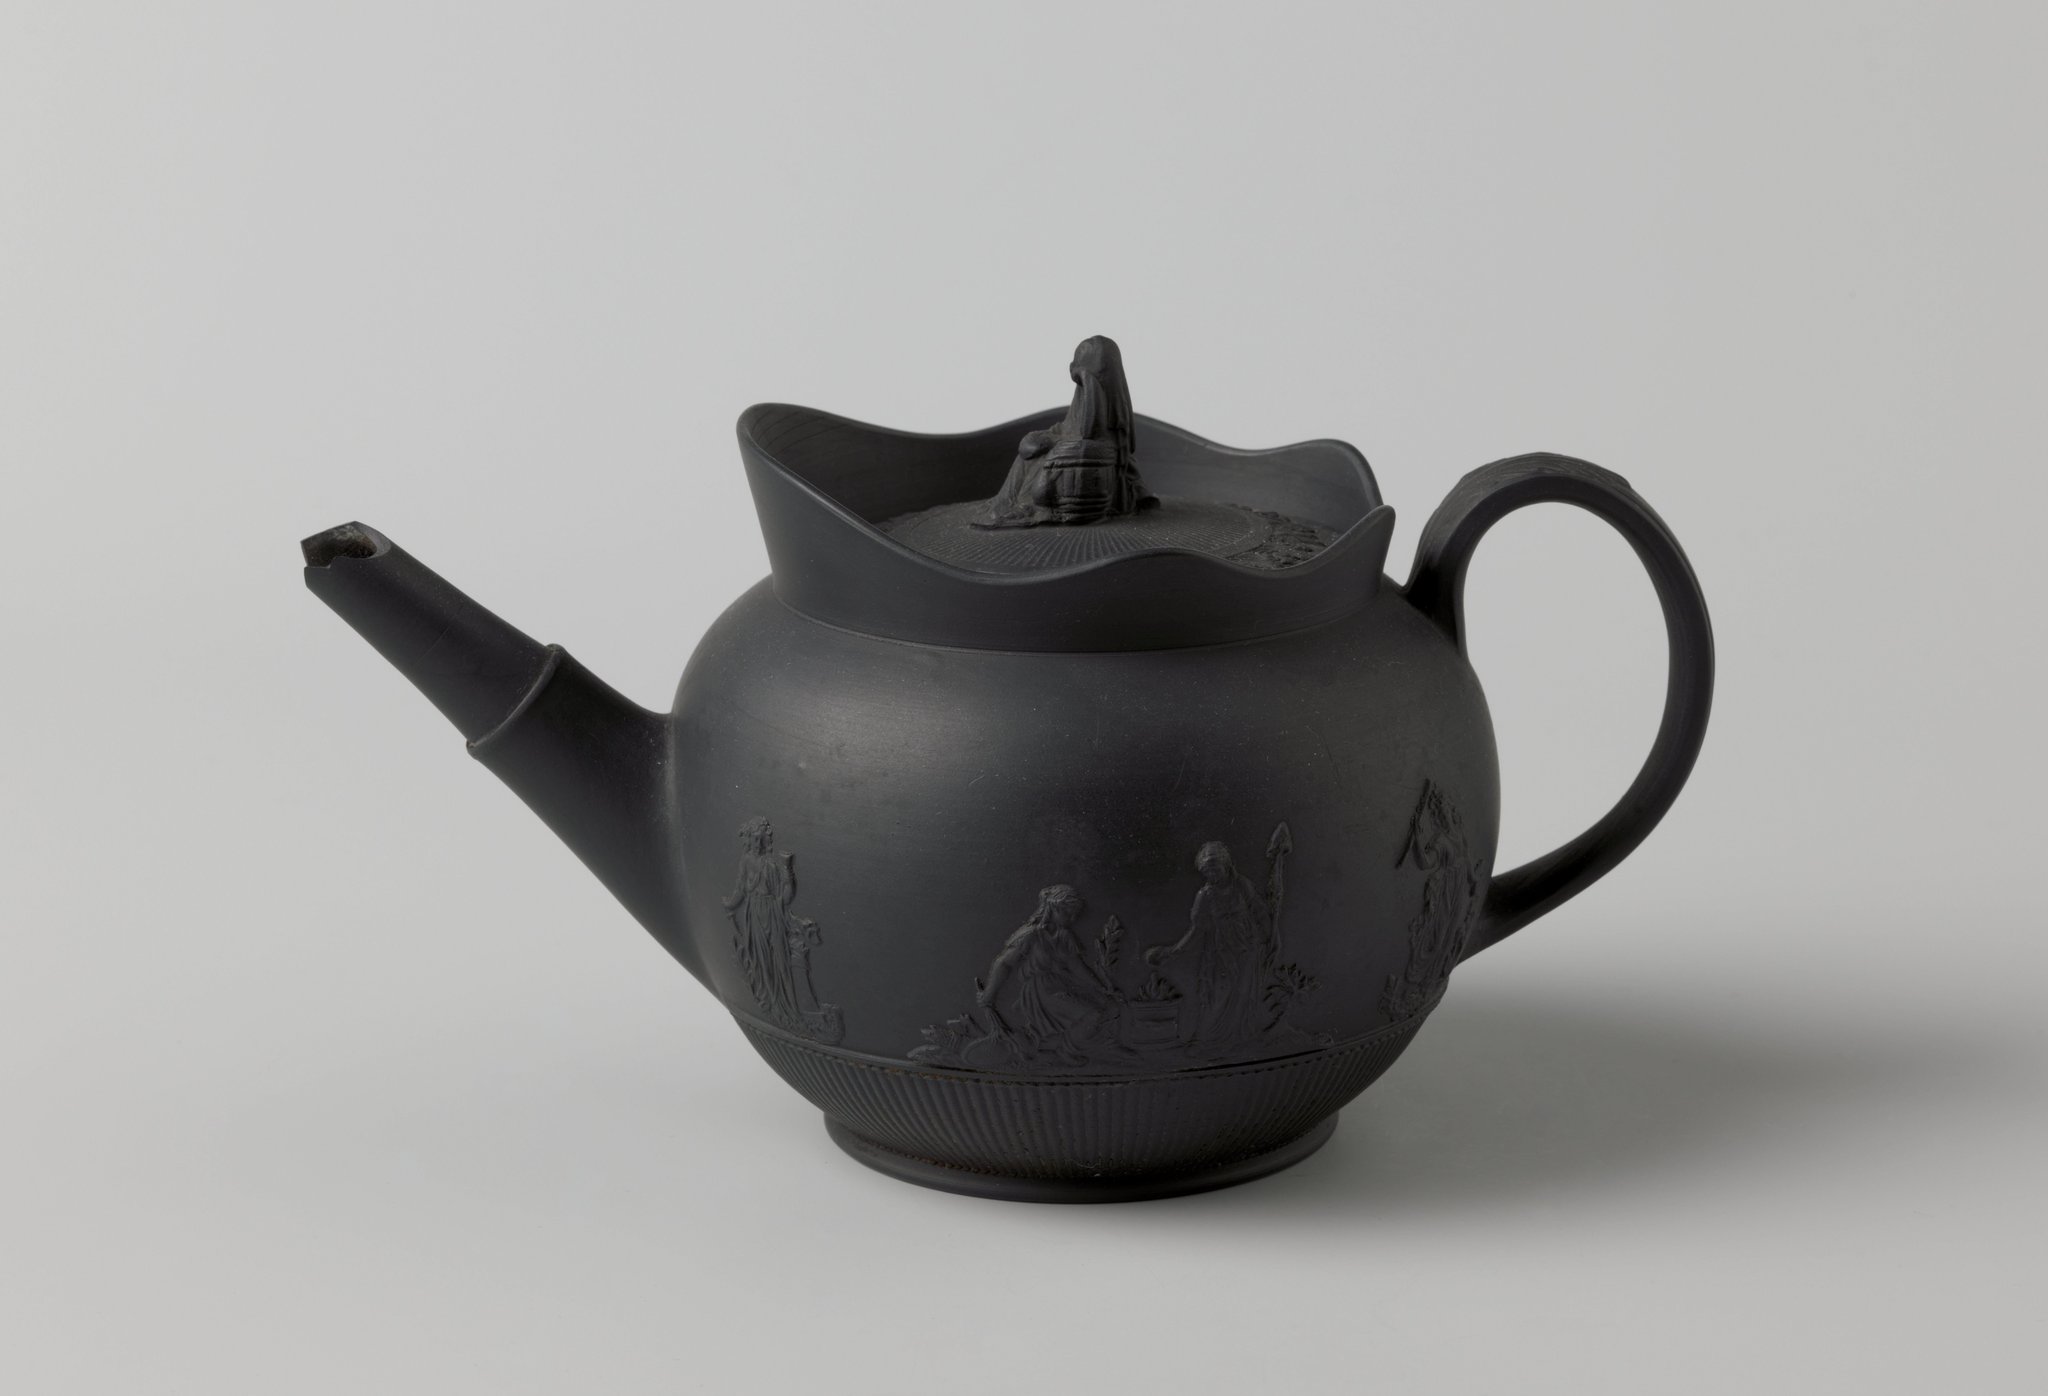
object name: teapot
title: Theepot van aardewerk, E.J. Birch Black Basalt. Met deksel.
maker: edmund john birch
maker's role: aardewerkfabriek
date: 1790-1810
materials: earthenware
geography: hanley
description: Bolvormige theepot met deksel van aardewerk, Black Basalt. De pot heeft een C-vormig oor, een rechte tuit en een opstaande, gegolfde rand. Het deksel heeft een knop in de vorm van een zittende vrouw met haar linkerarm rustend op een vat. De buik van de pot is in reliëf versierd met allegorische vrouwen en musicerende kinderen.